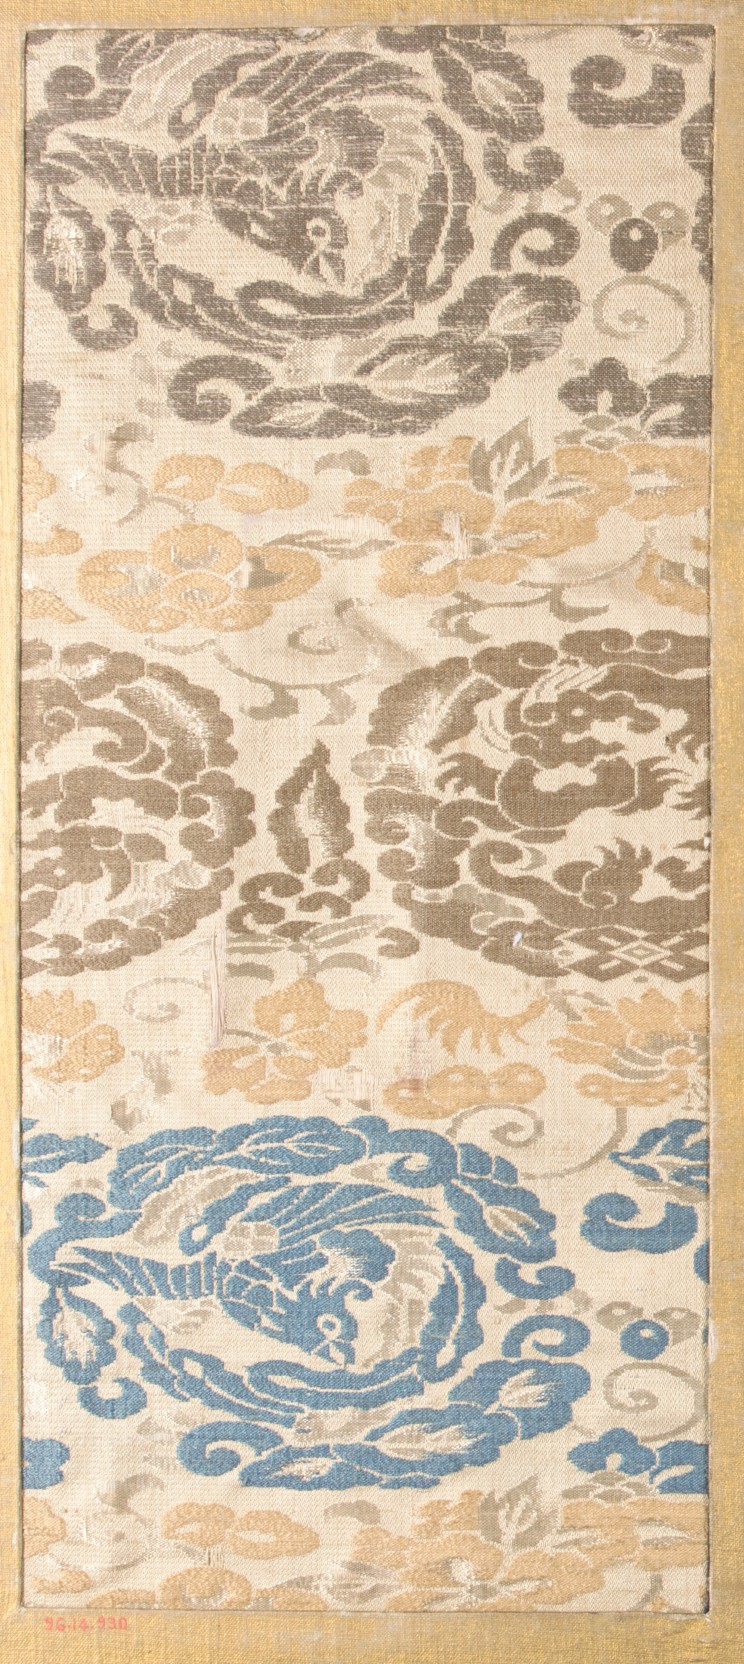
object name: piece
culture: japanese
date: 1701-1900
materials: silk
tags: flowers